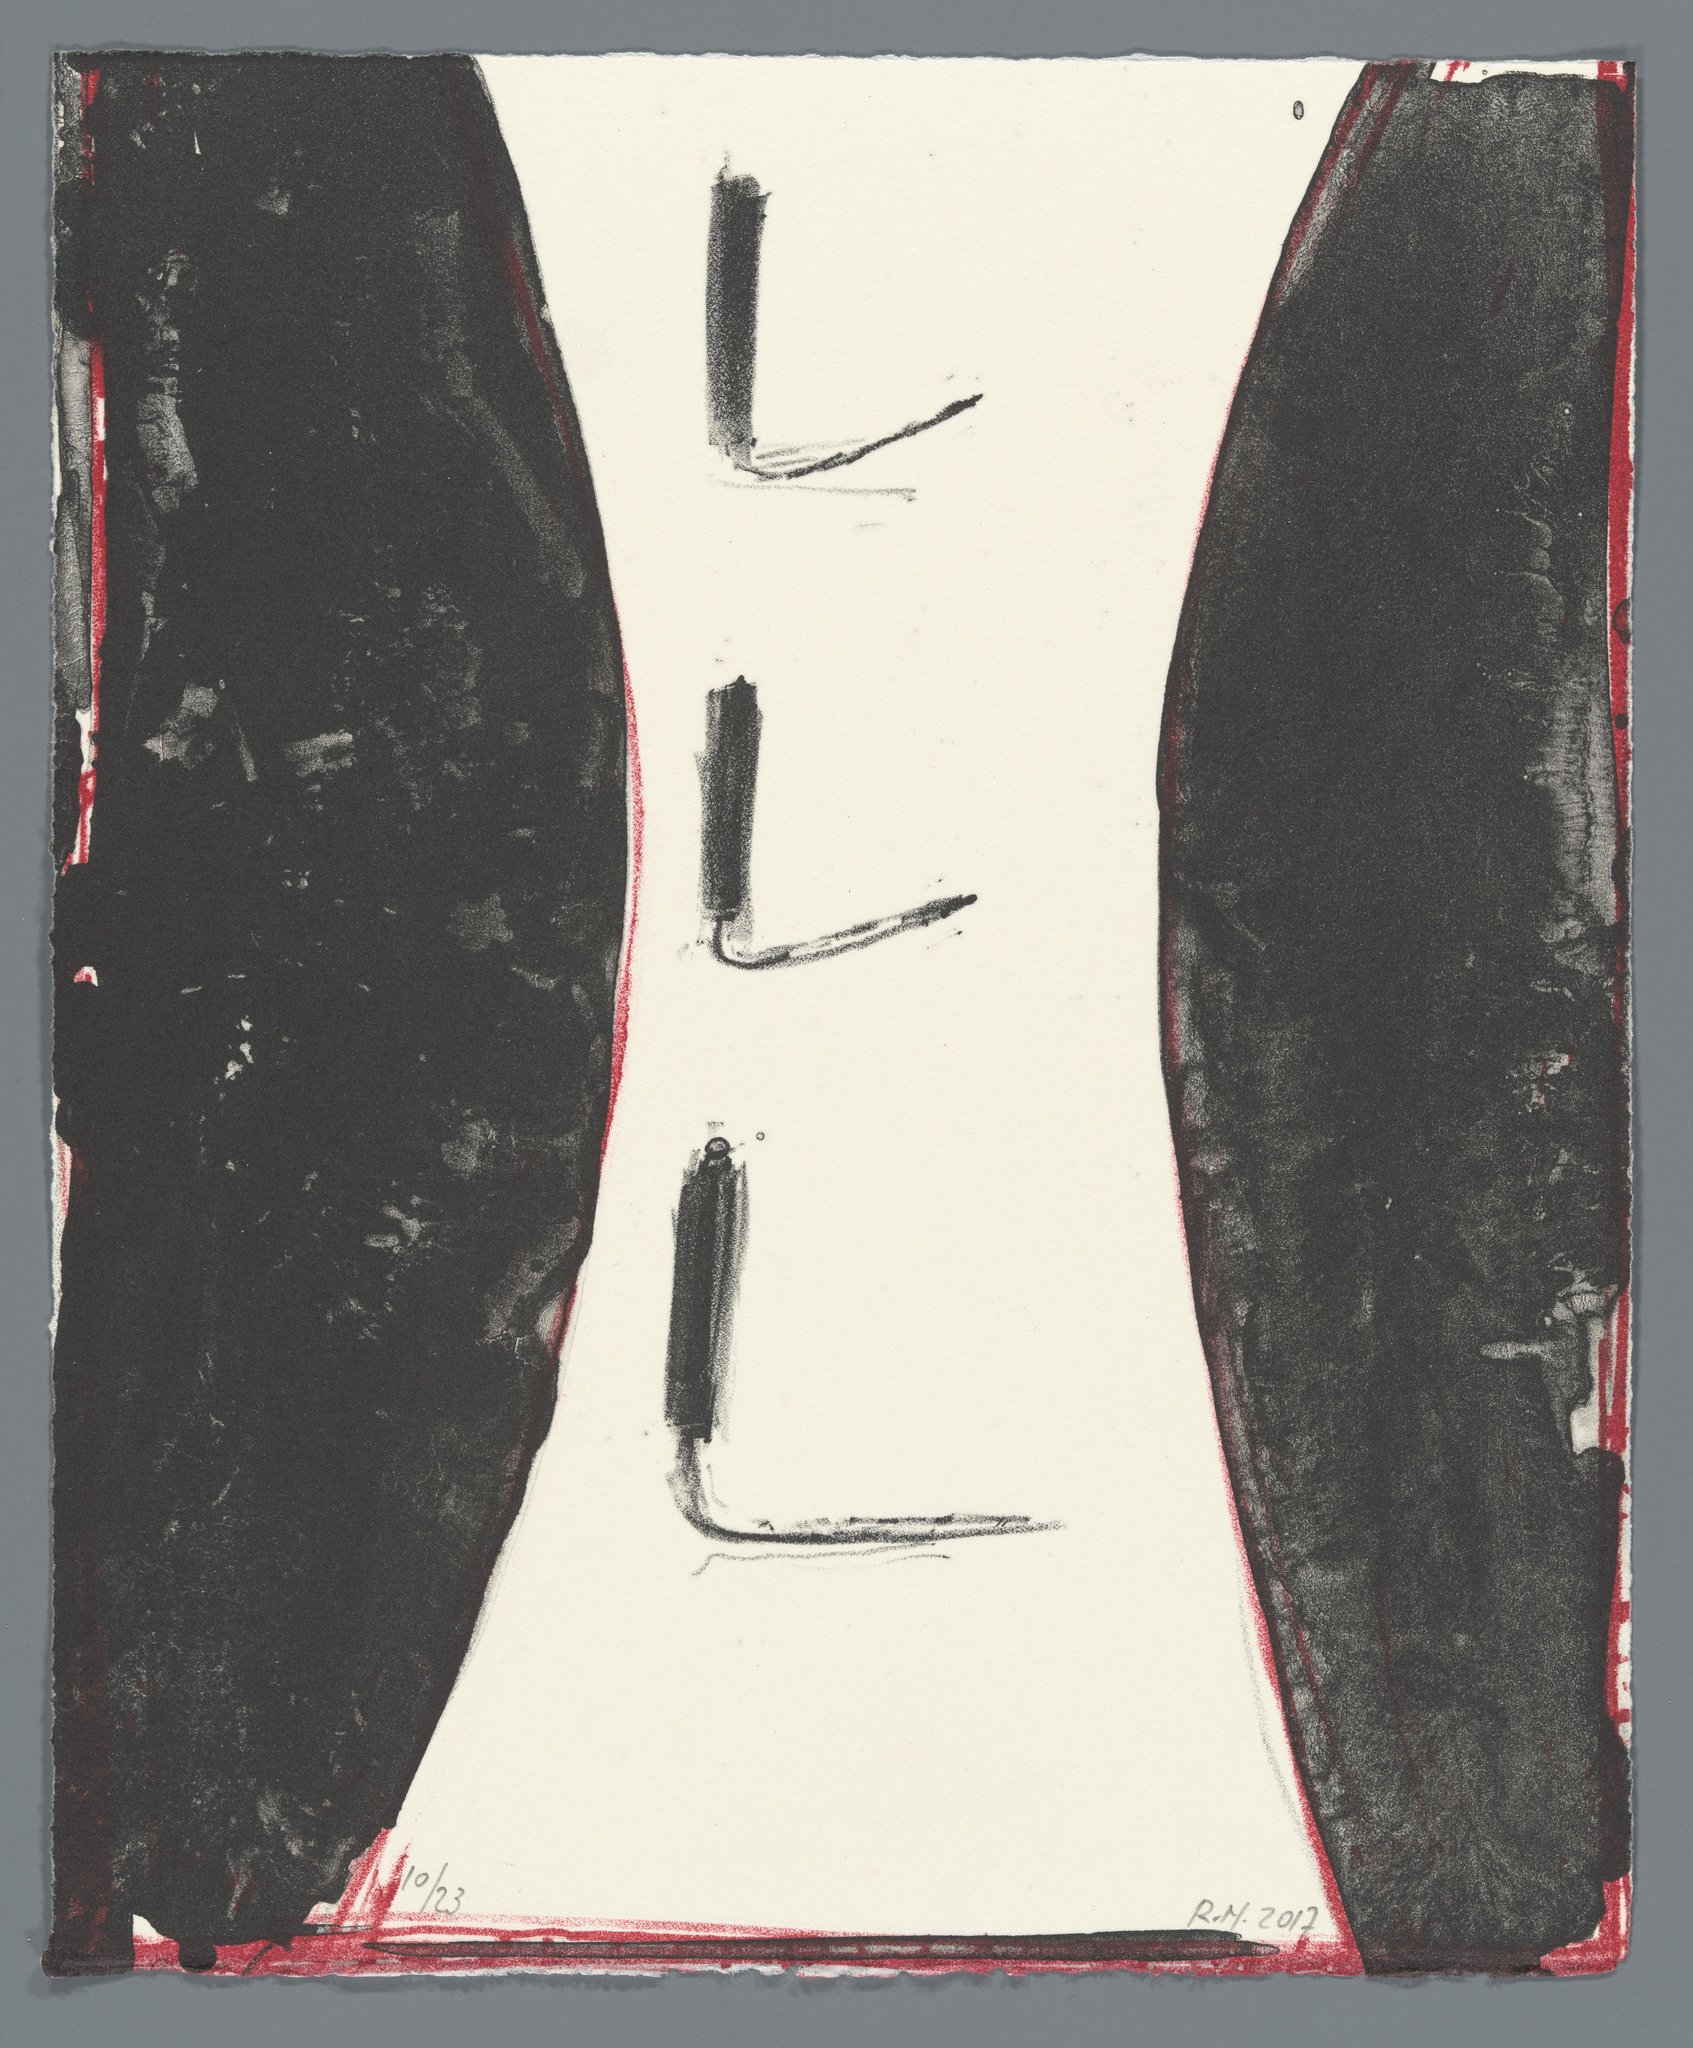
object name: print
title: nr. 693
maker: ronald noorman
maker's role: draughtsman, print maker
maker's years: 1951-2018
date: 2017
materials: ink, paper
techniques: lithograph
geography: amsterdam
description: Zwarte lijn verdelen het vlak horizontaal en omkaderen het deel onder de lijn. Er boven is een smalle lineaire vorm met daarin een rood vierkant.